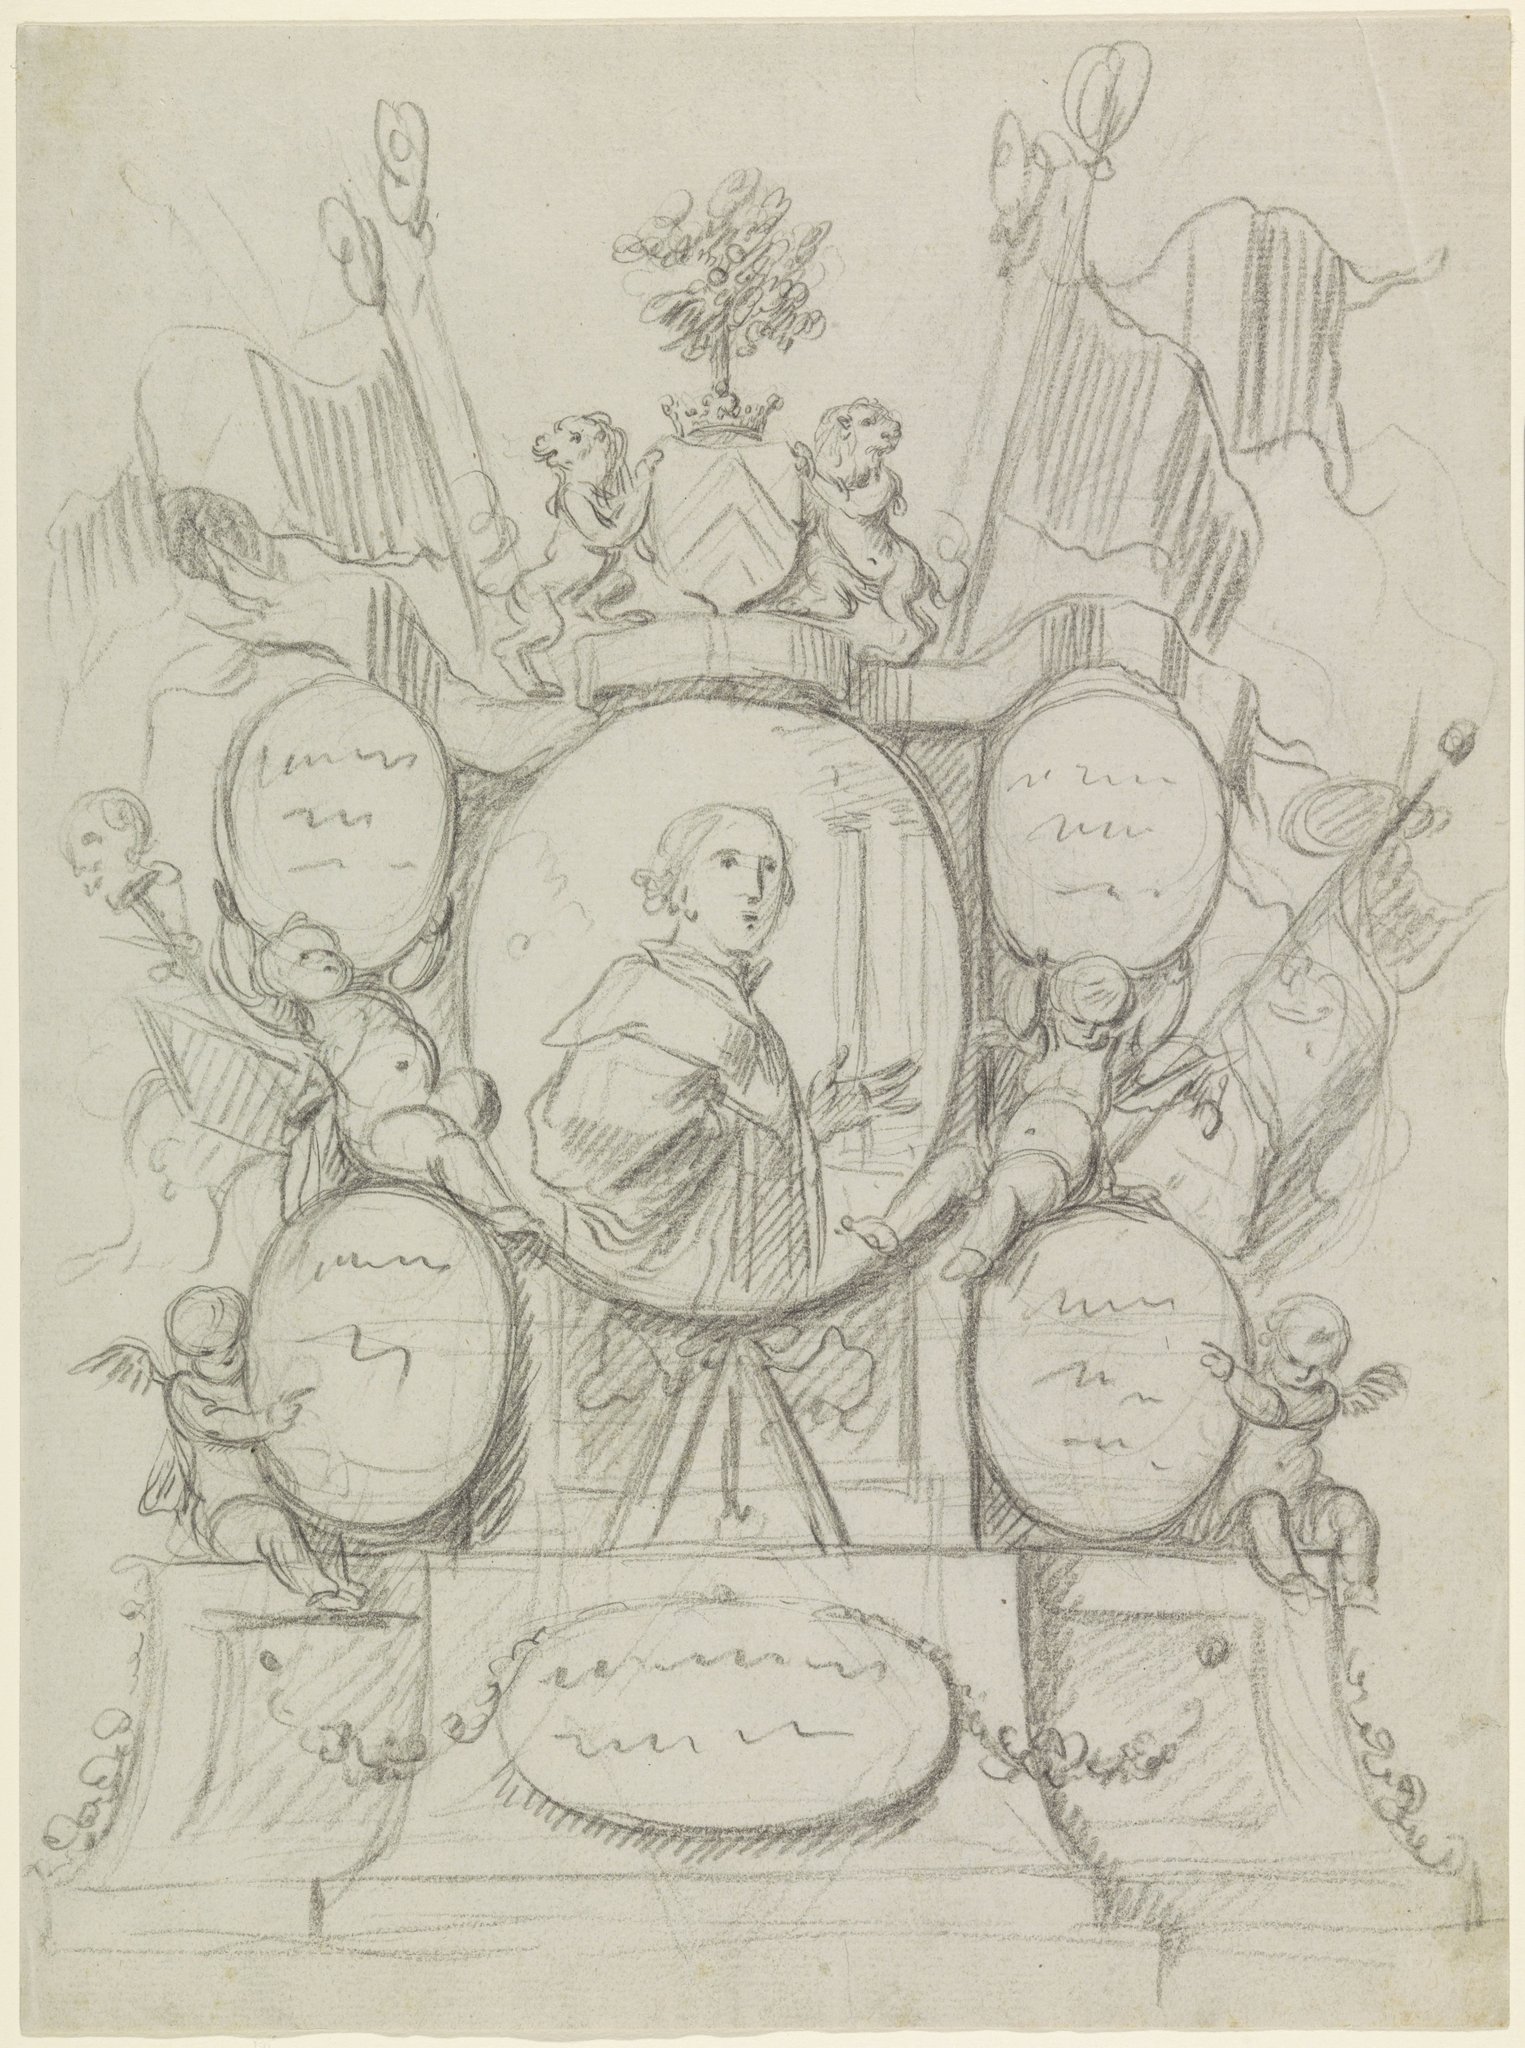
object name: drawing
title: Grafmonument met medaillons en putti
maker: Anonymous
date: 1650-1800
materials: chalk, paper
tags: ornament ~ medallion, grave, tomb, cupids: 'amores', 'amoretti', 'putti'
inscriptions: collector's mark: Lugt 2228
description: Een grafmonument met putti met medaillons. In het midden een medaillon met een mannenportret. Rondom wapens en vlaggen. Aan de bovenzijde flankeren twee leeuwen een gekroond wapenschild met kepers en een boom.